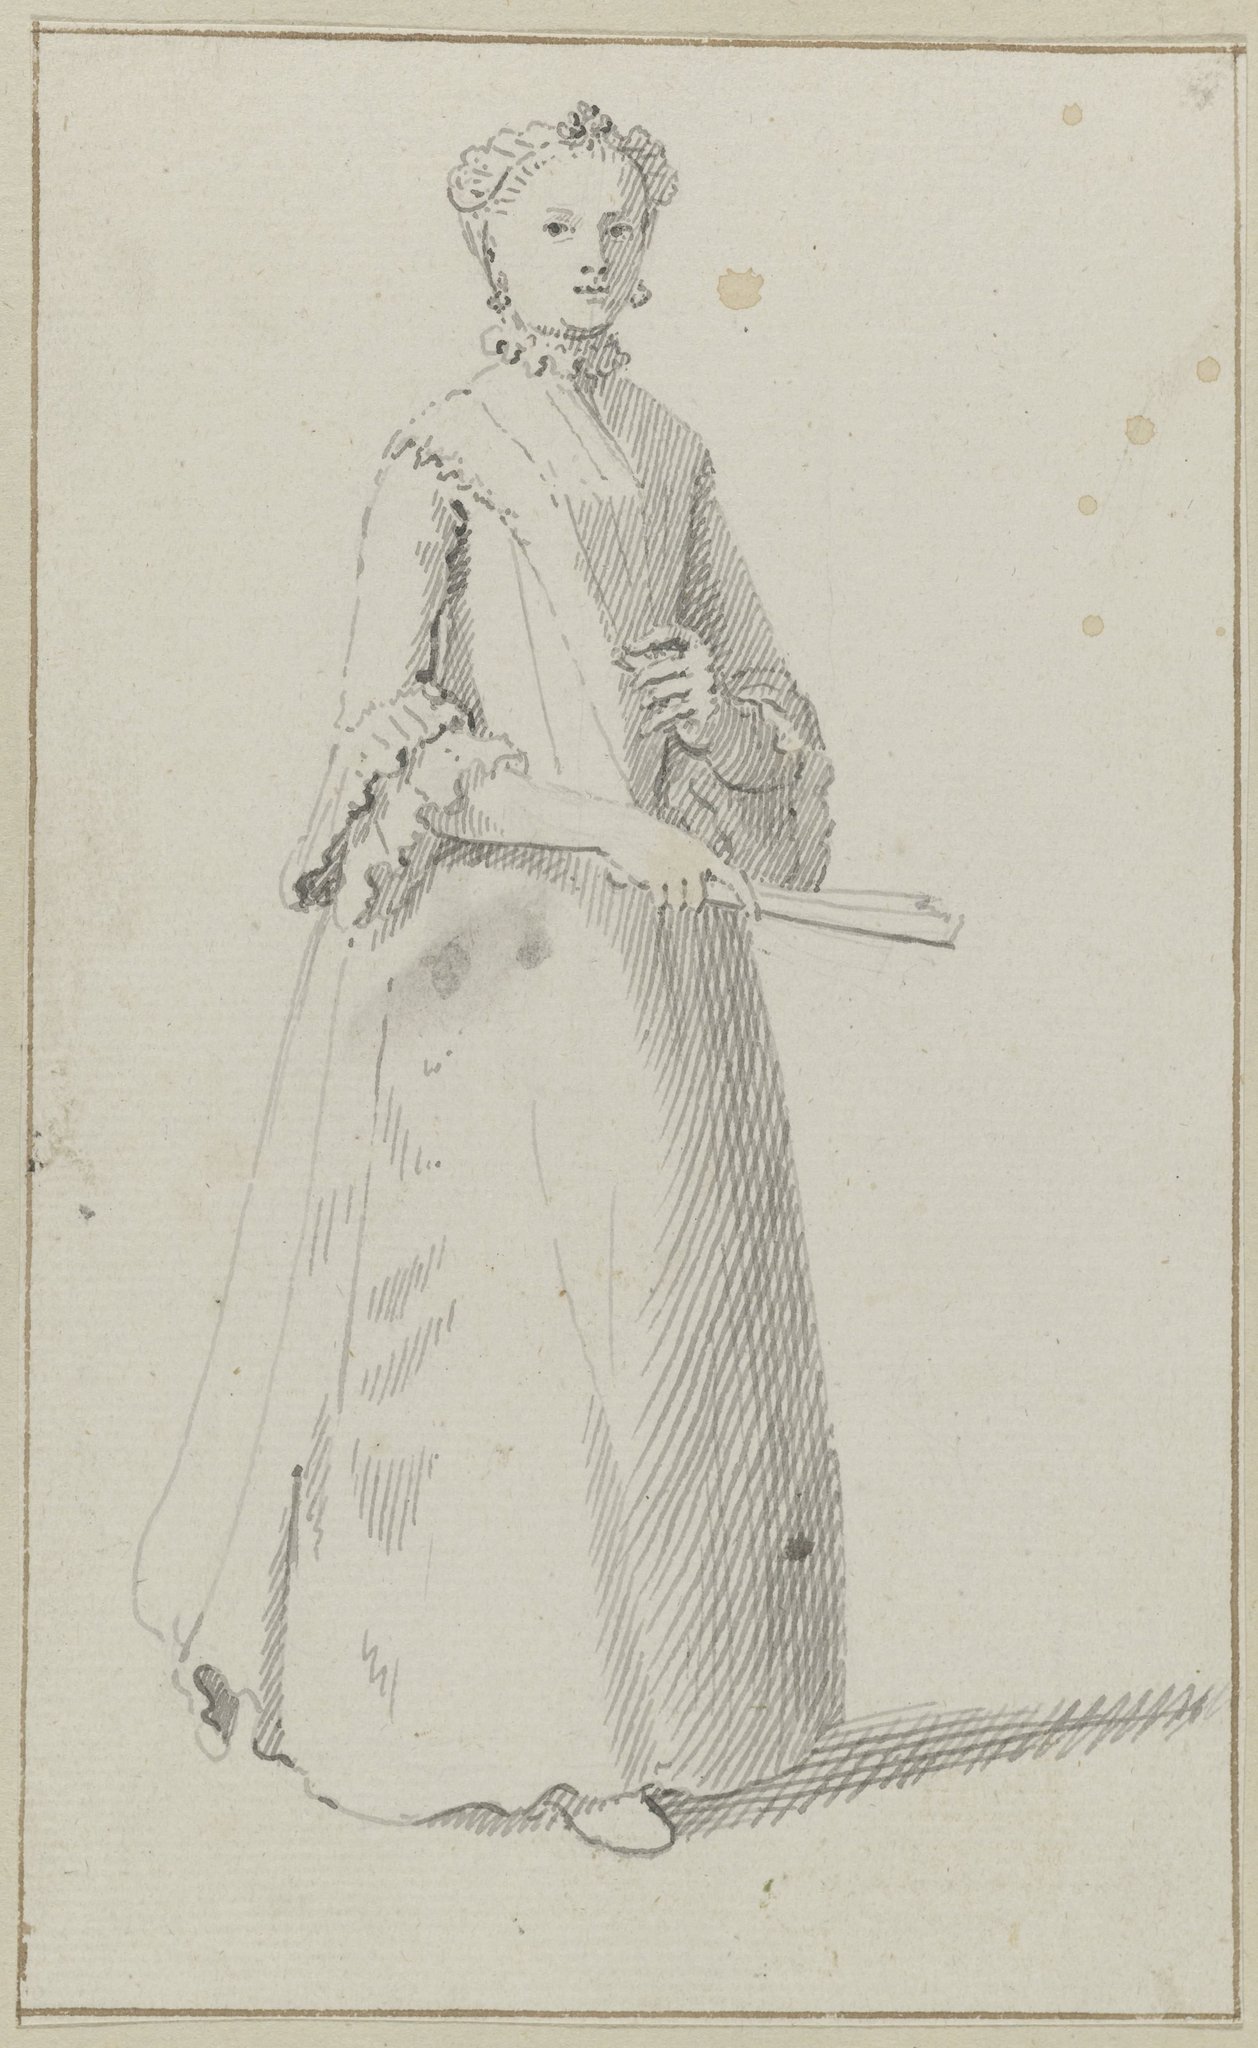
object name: drawing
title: Staande vrouw met gevouwen waaier in haar hand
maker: Anonymous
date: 1700-1799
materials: ink, paper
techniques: pen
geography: netherlands